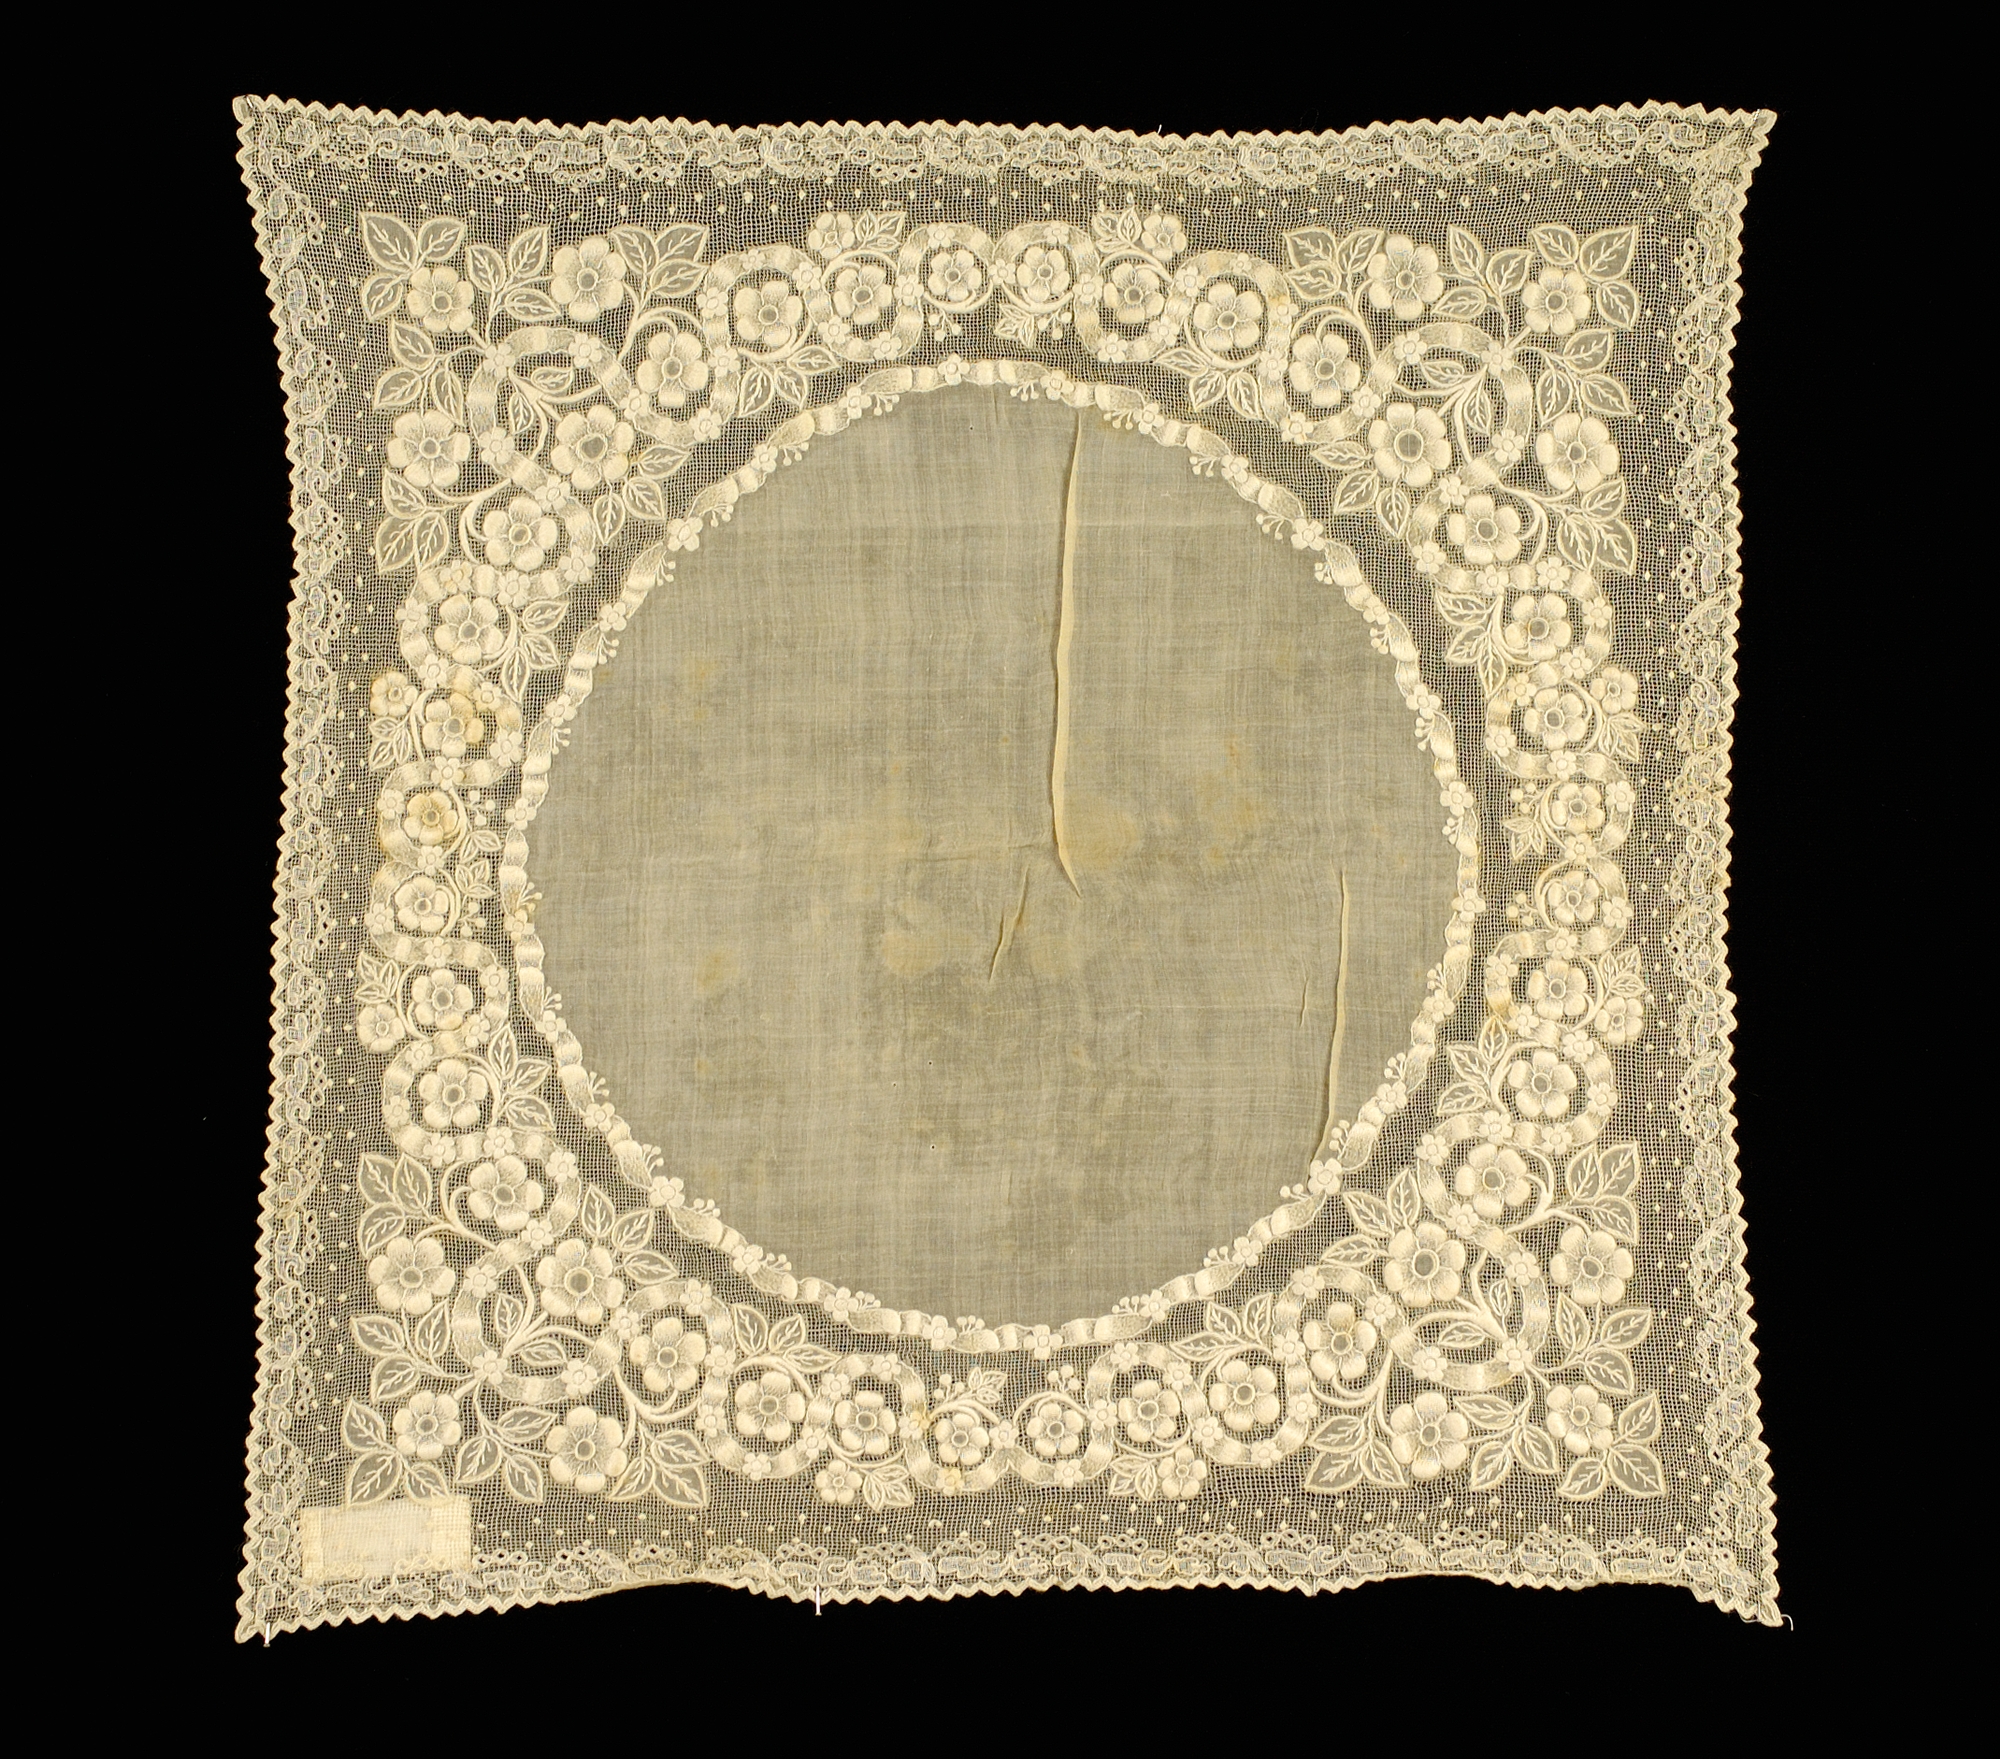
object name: handkerchief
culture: philippine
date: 1851-1875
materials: fiber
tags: flowers